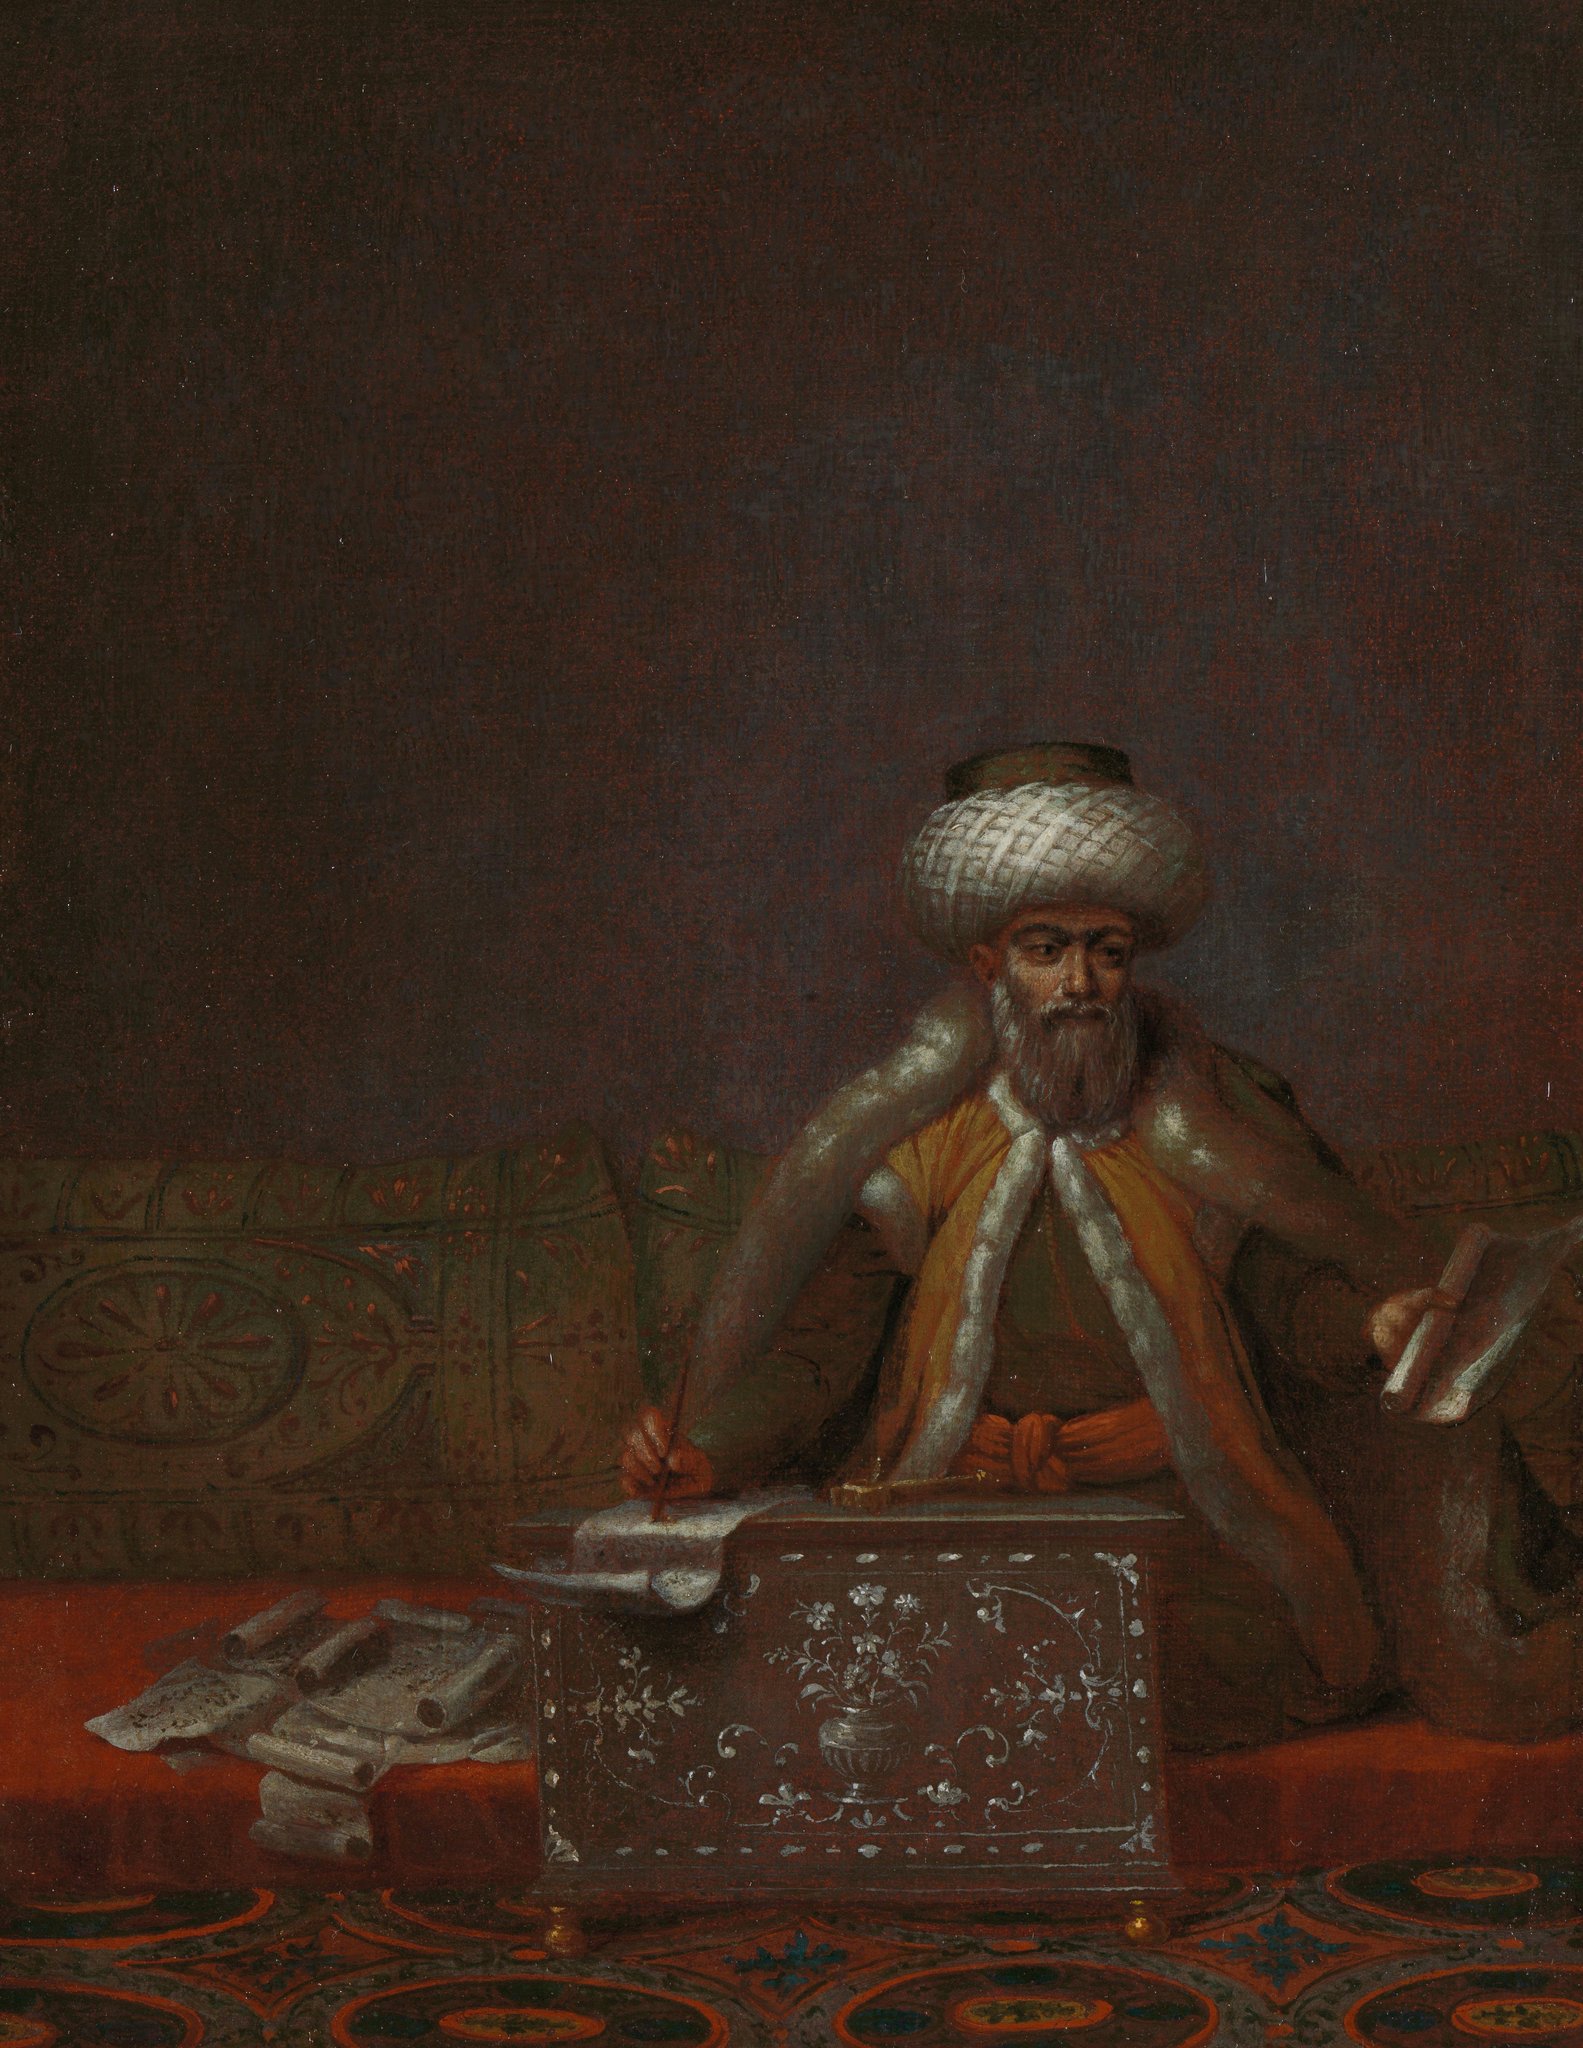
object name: painting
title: The Reis Effendi, Head of the Chancery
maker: jean baptiste vanmour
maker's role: painter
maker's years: 1671-1737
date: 1727-1730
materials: canvas, oil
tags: writing accessories, historical persons not known by name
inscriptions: inscription: ‘Mehemet Reis Effendi’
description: The office of reis effendi or reisü’l küttab, the head of the chancery, could be likened to the minister of foreign affairs. This official at the Ottoman court had the most contact with Western diplomats. Ambassador Calkoen would have met him on a regular basis.